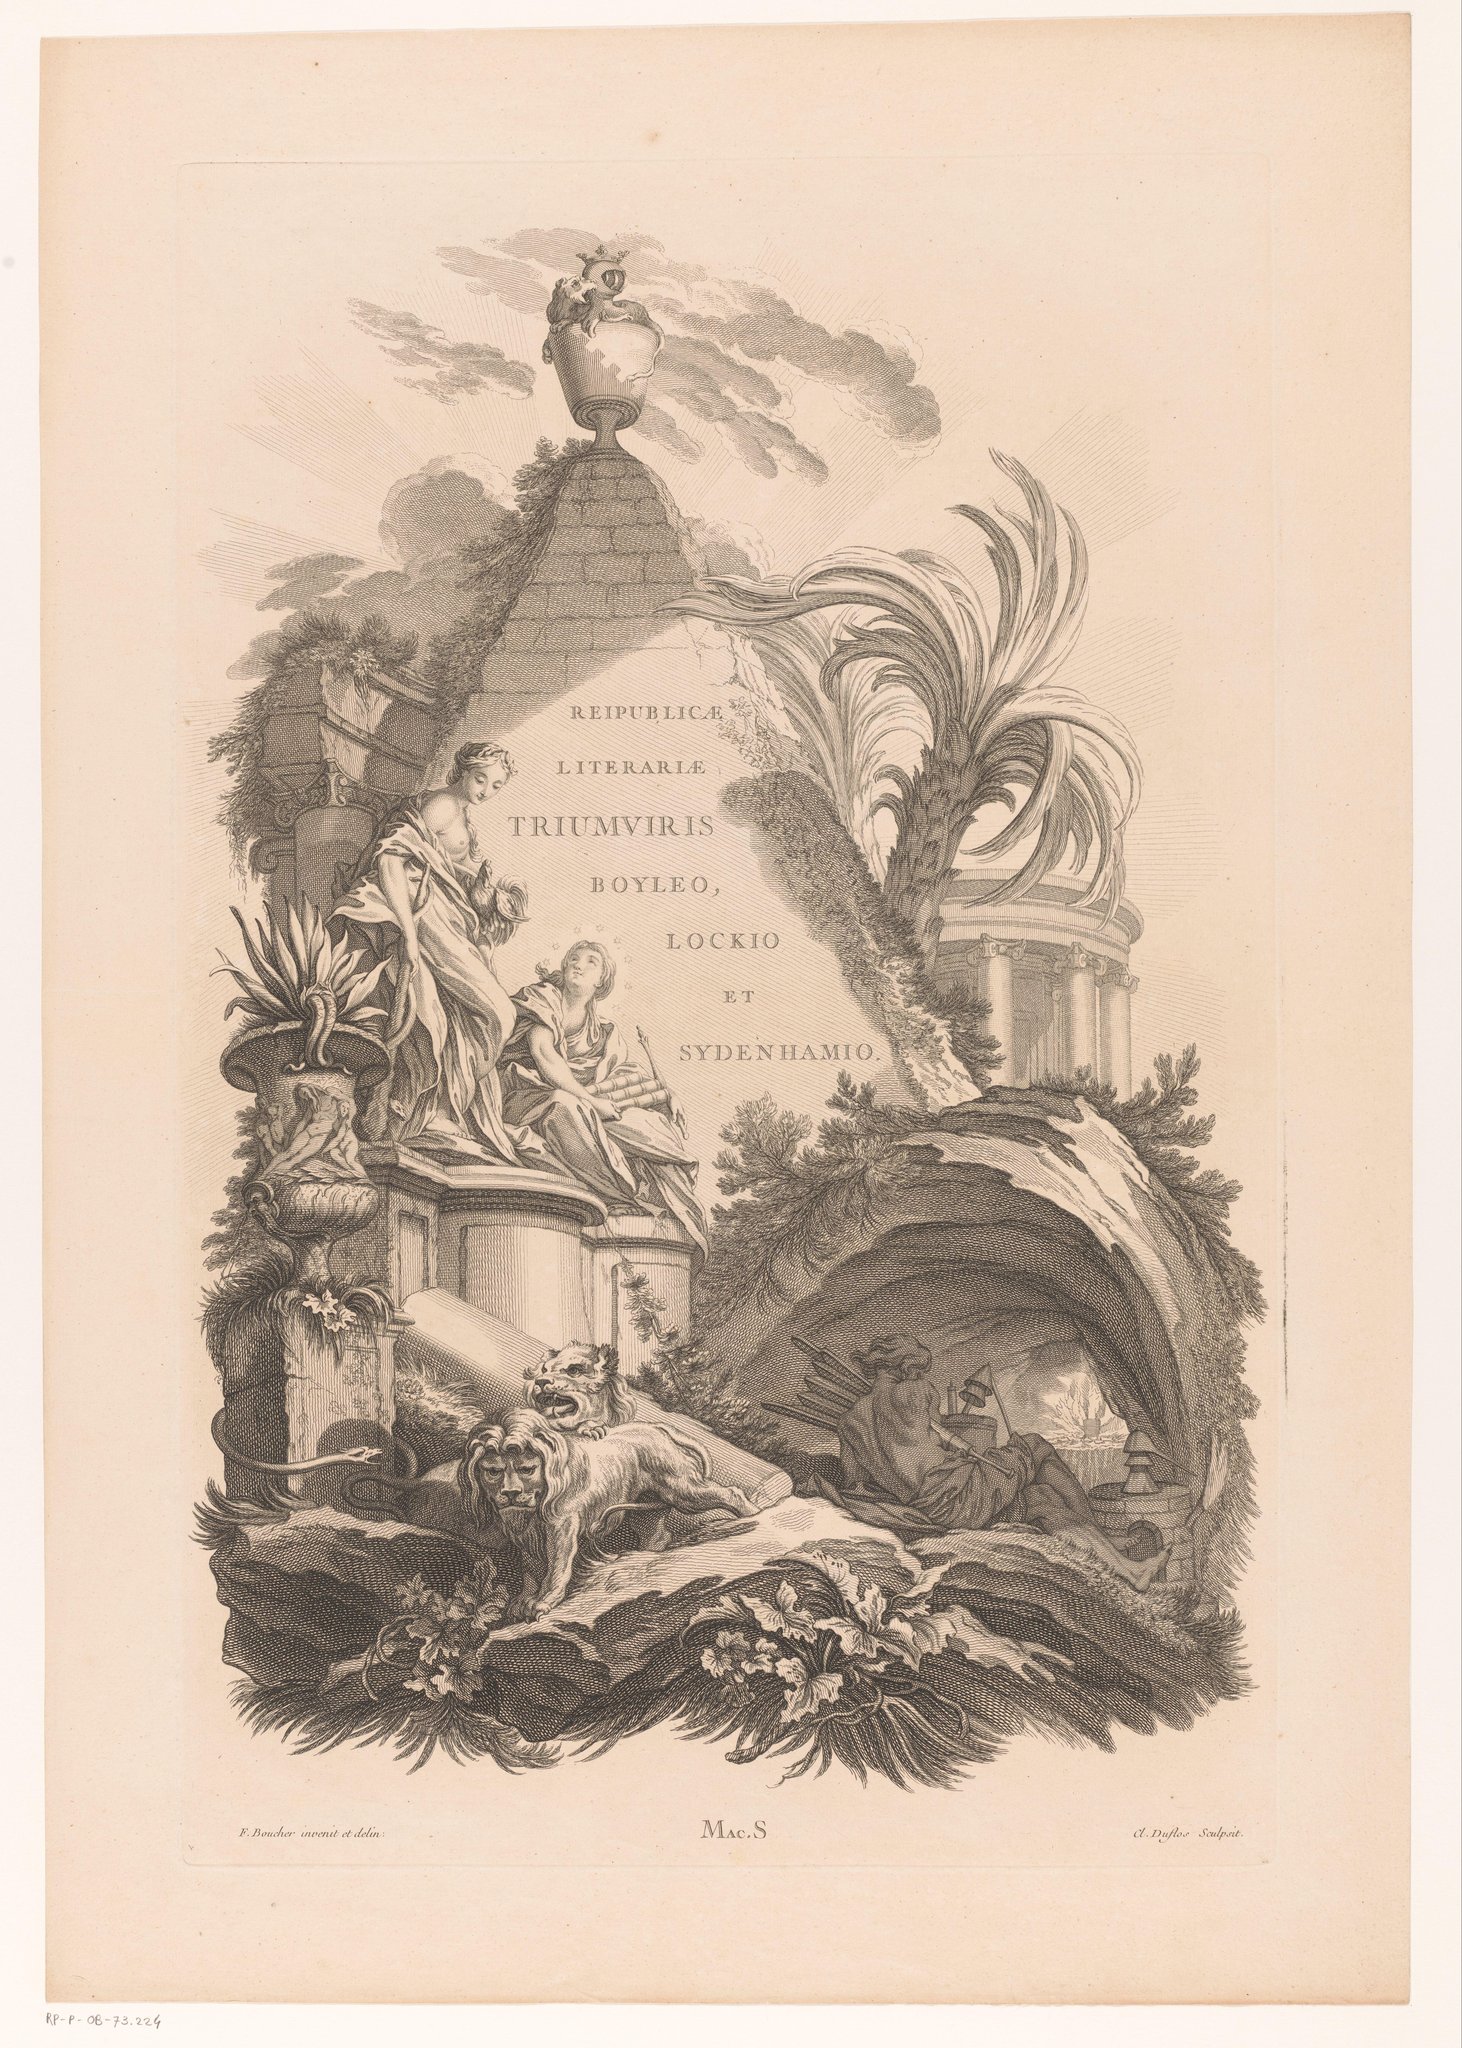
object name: print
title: Tombeaux des princes et des grands capitaines et autres hommes illustres qui ont fleuri dans la Grande Bretagne vers la fin du XVIIe et le commencement du XVIIIe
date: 1735-1741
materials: paper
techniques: engraving, etching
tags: politician, physicist, london, beasts of prey, predatory animals: lion, alertness, vigilance; 'guardia', 'vigilanza', 'vigilanza per difendersi & oppugnare altri' (ripa)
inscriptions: collector's mark: Lugt 2228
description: Maakt deel uit van een twintigdelige serie met prenten van grafmonumenten van illustere Britten naar schilderijen uit de collectie van de Duke of Richmond. De serie bestaat uit prenten door verschillende kunstenaars en werd eerst uitgegeven door Mac Swiny en daarna door Basan. Dit betreft de prent voorafgaand aan het allegorisch grafmonument voor Robert Boyle, John Locke en Thomas Sydenham.